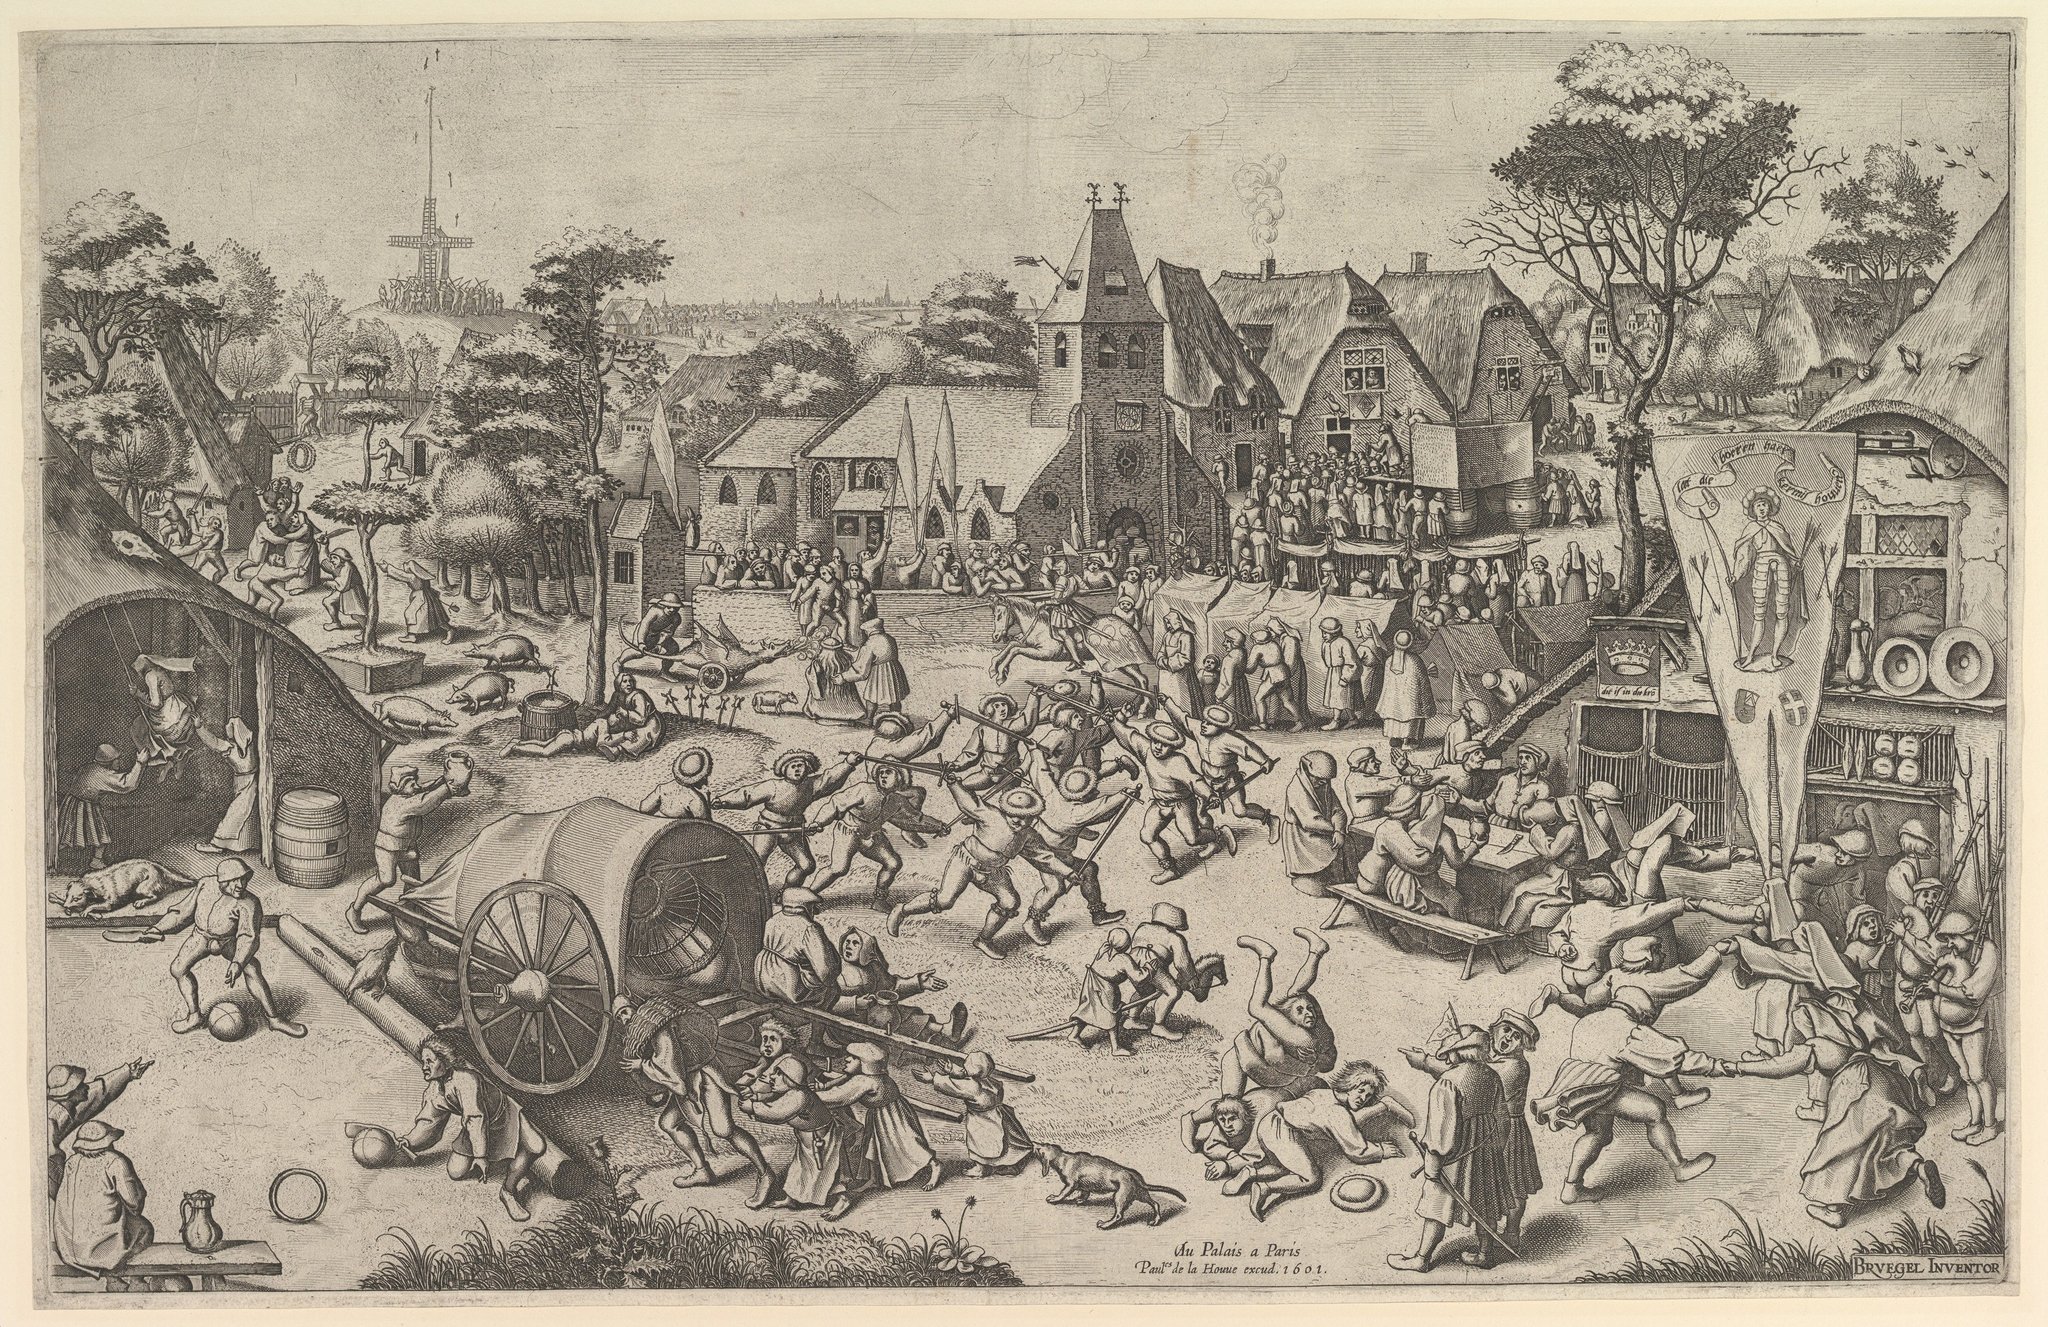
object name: print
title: The Kermis of Saint George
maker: johannes van doetecum i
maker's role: artist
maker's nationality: netherlandish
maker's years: 1528-1605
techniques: engraving, etching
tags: musical instruments,towns,dancing,dogs,pigs,carts,games